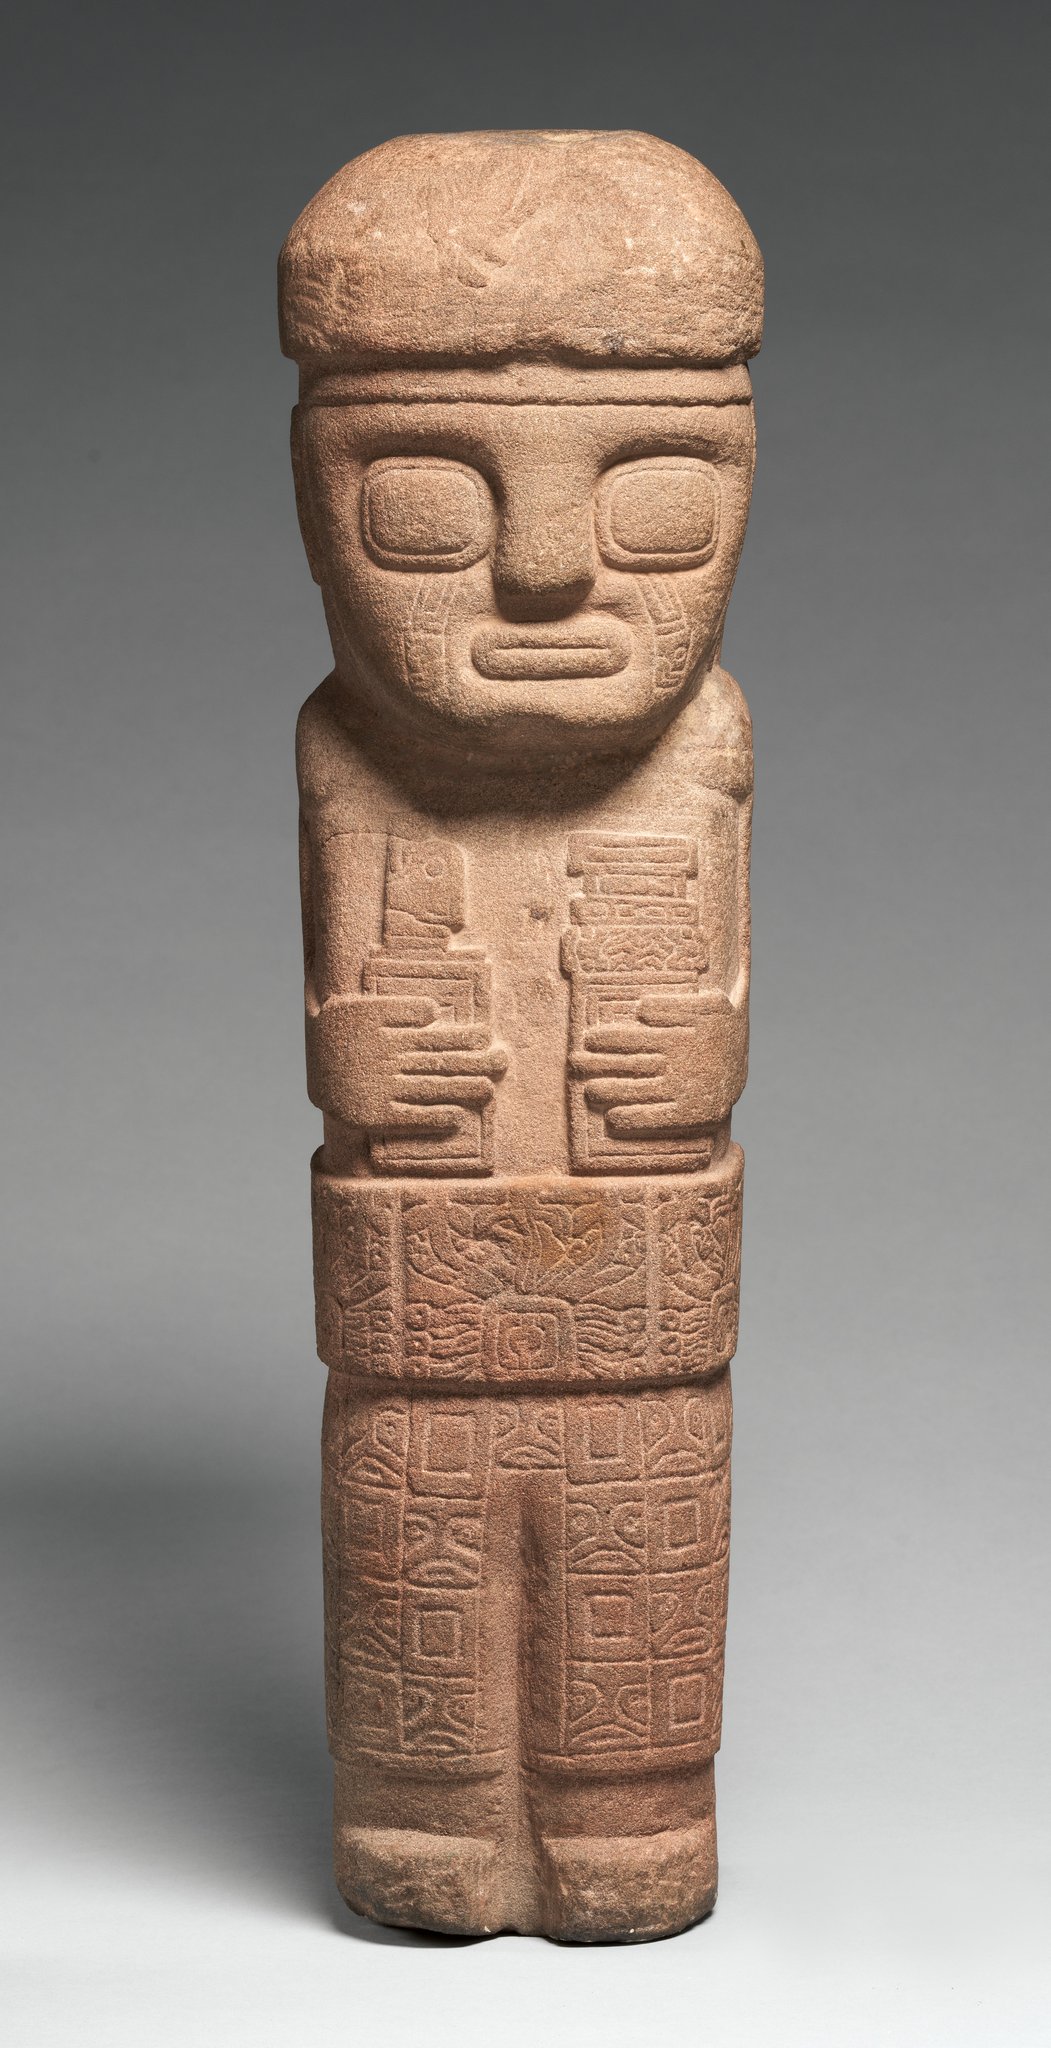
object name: male figure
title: Standing figure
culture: tiwanaku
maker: tiwanaku artist(s)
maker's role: artist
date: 500-1000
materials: stone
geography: bolivia